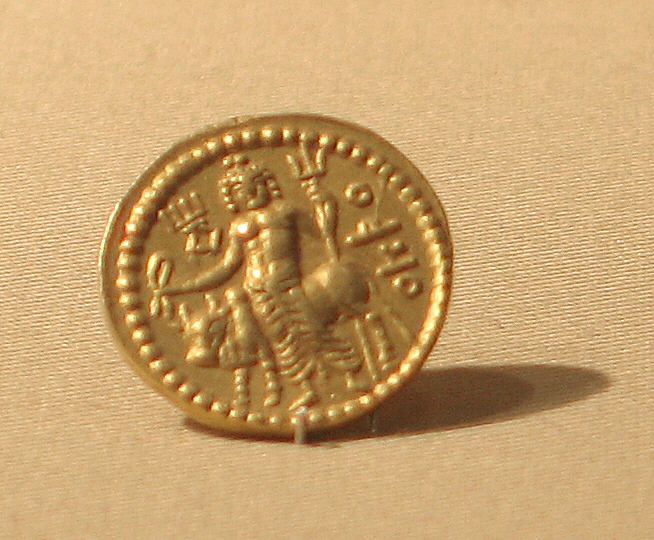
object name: coin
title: Coin of Vasudeva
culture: gandhara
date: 185-220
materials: gold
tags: animals,gandhara